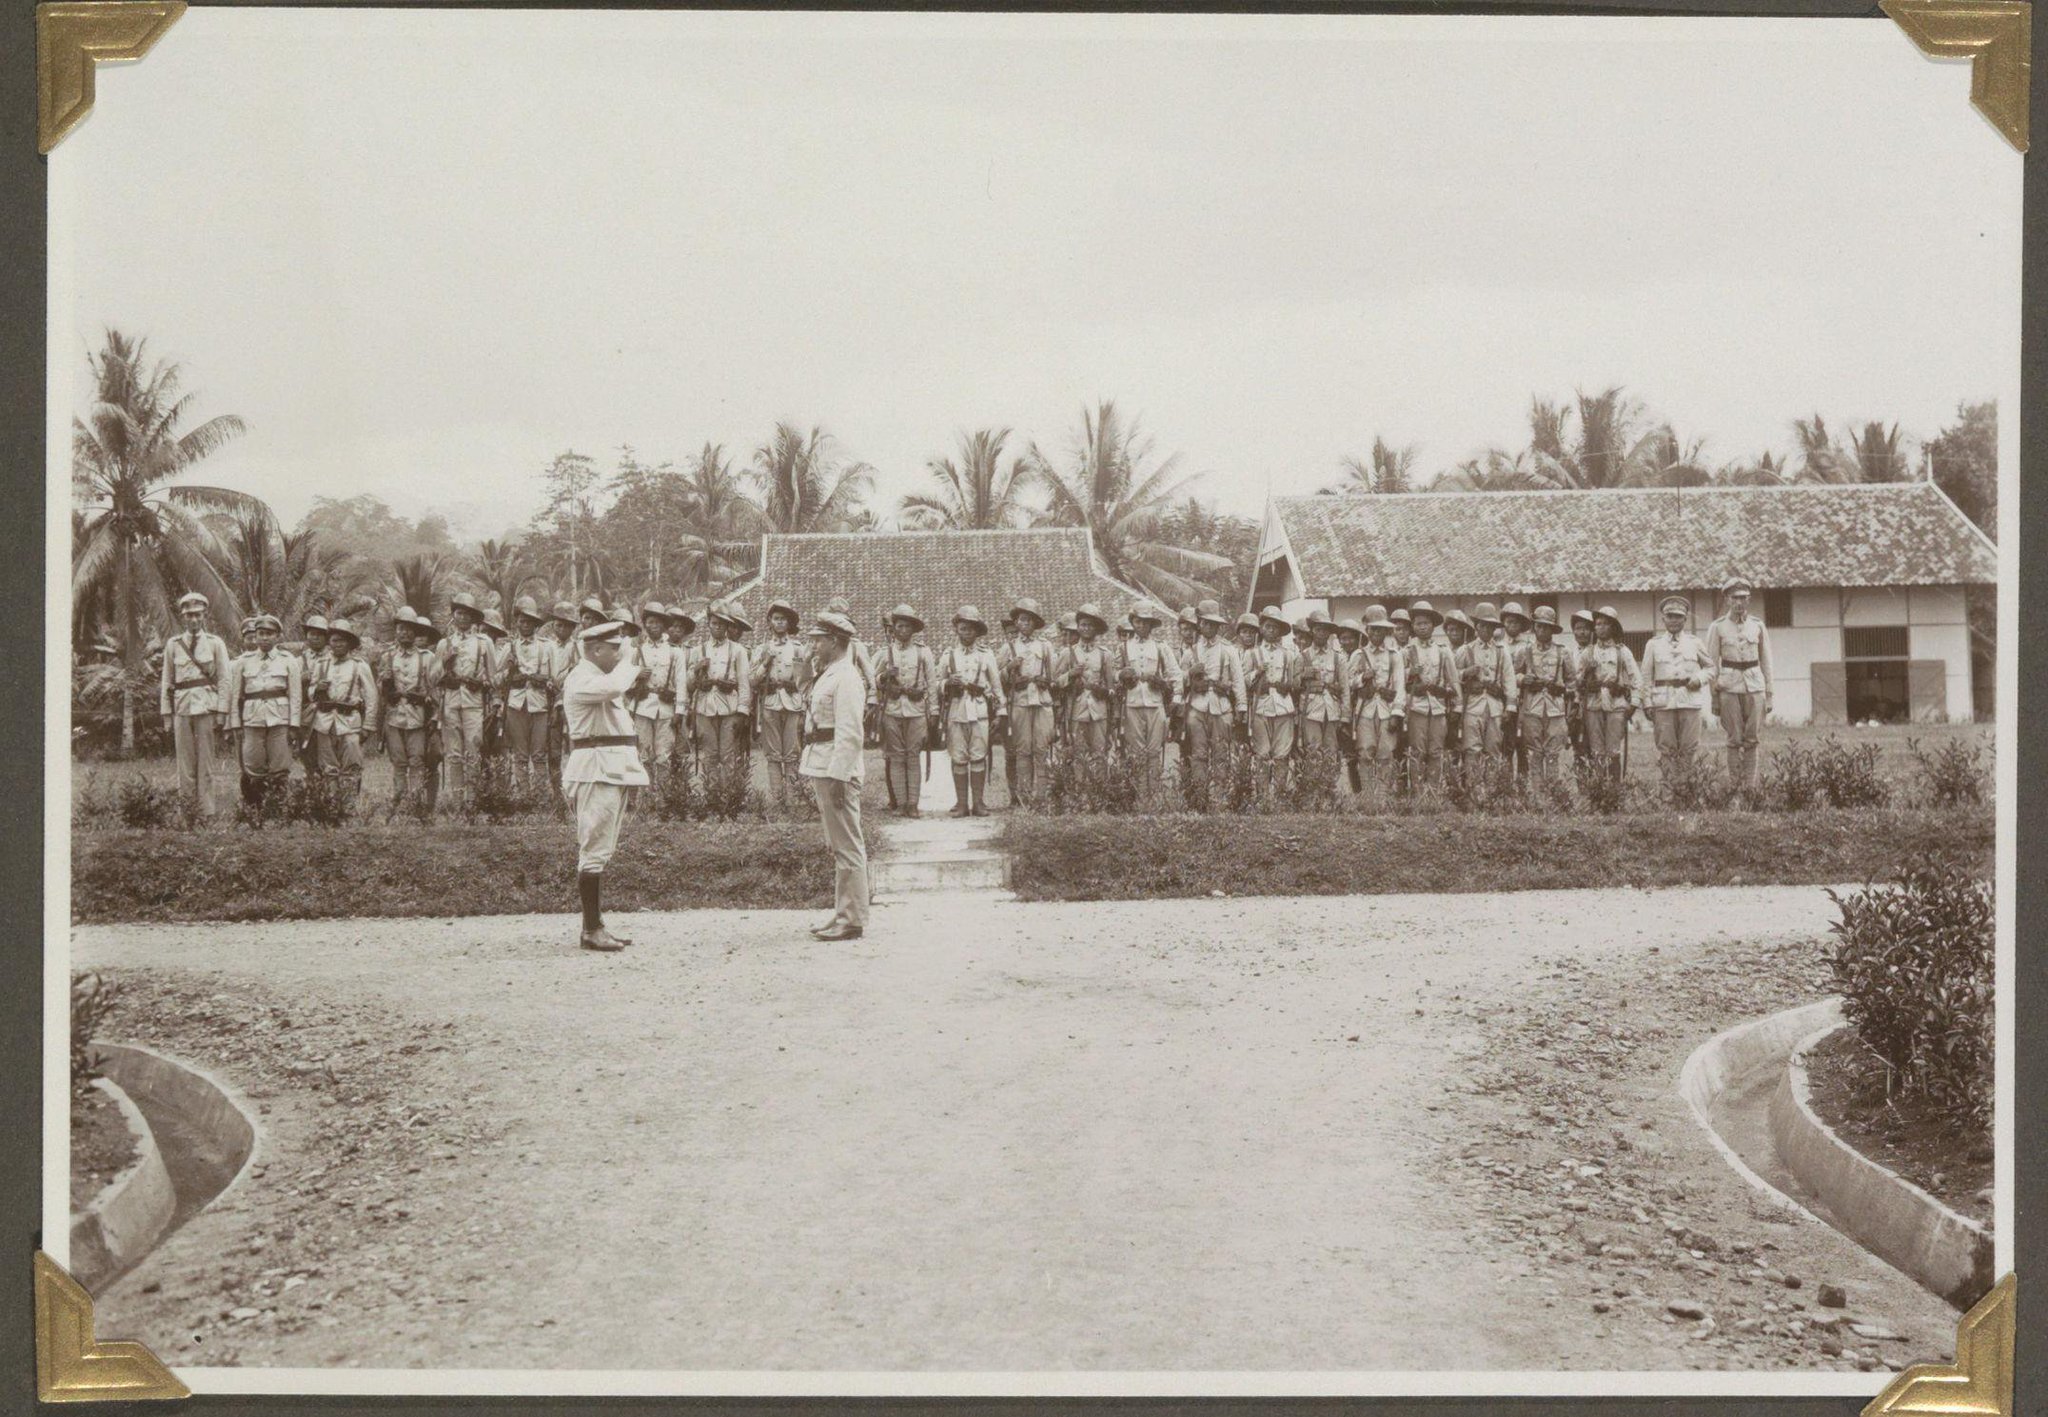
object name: photograph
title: Morgen-appel. Een Inspecteur van Politie meldt het Detachement present bij den Hoofdinspecteur-Detachements Commandant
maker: Anonymous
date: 1932-1933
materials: photographic support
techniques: gelatin silver print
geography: lampung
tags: police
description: Onderdeel van Herinneringsalbum voor F.J. Junius, vertrekkend resident van Lampong (Zuid-Sumatra).